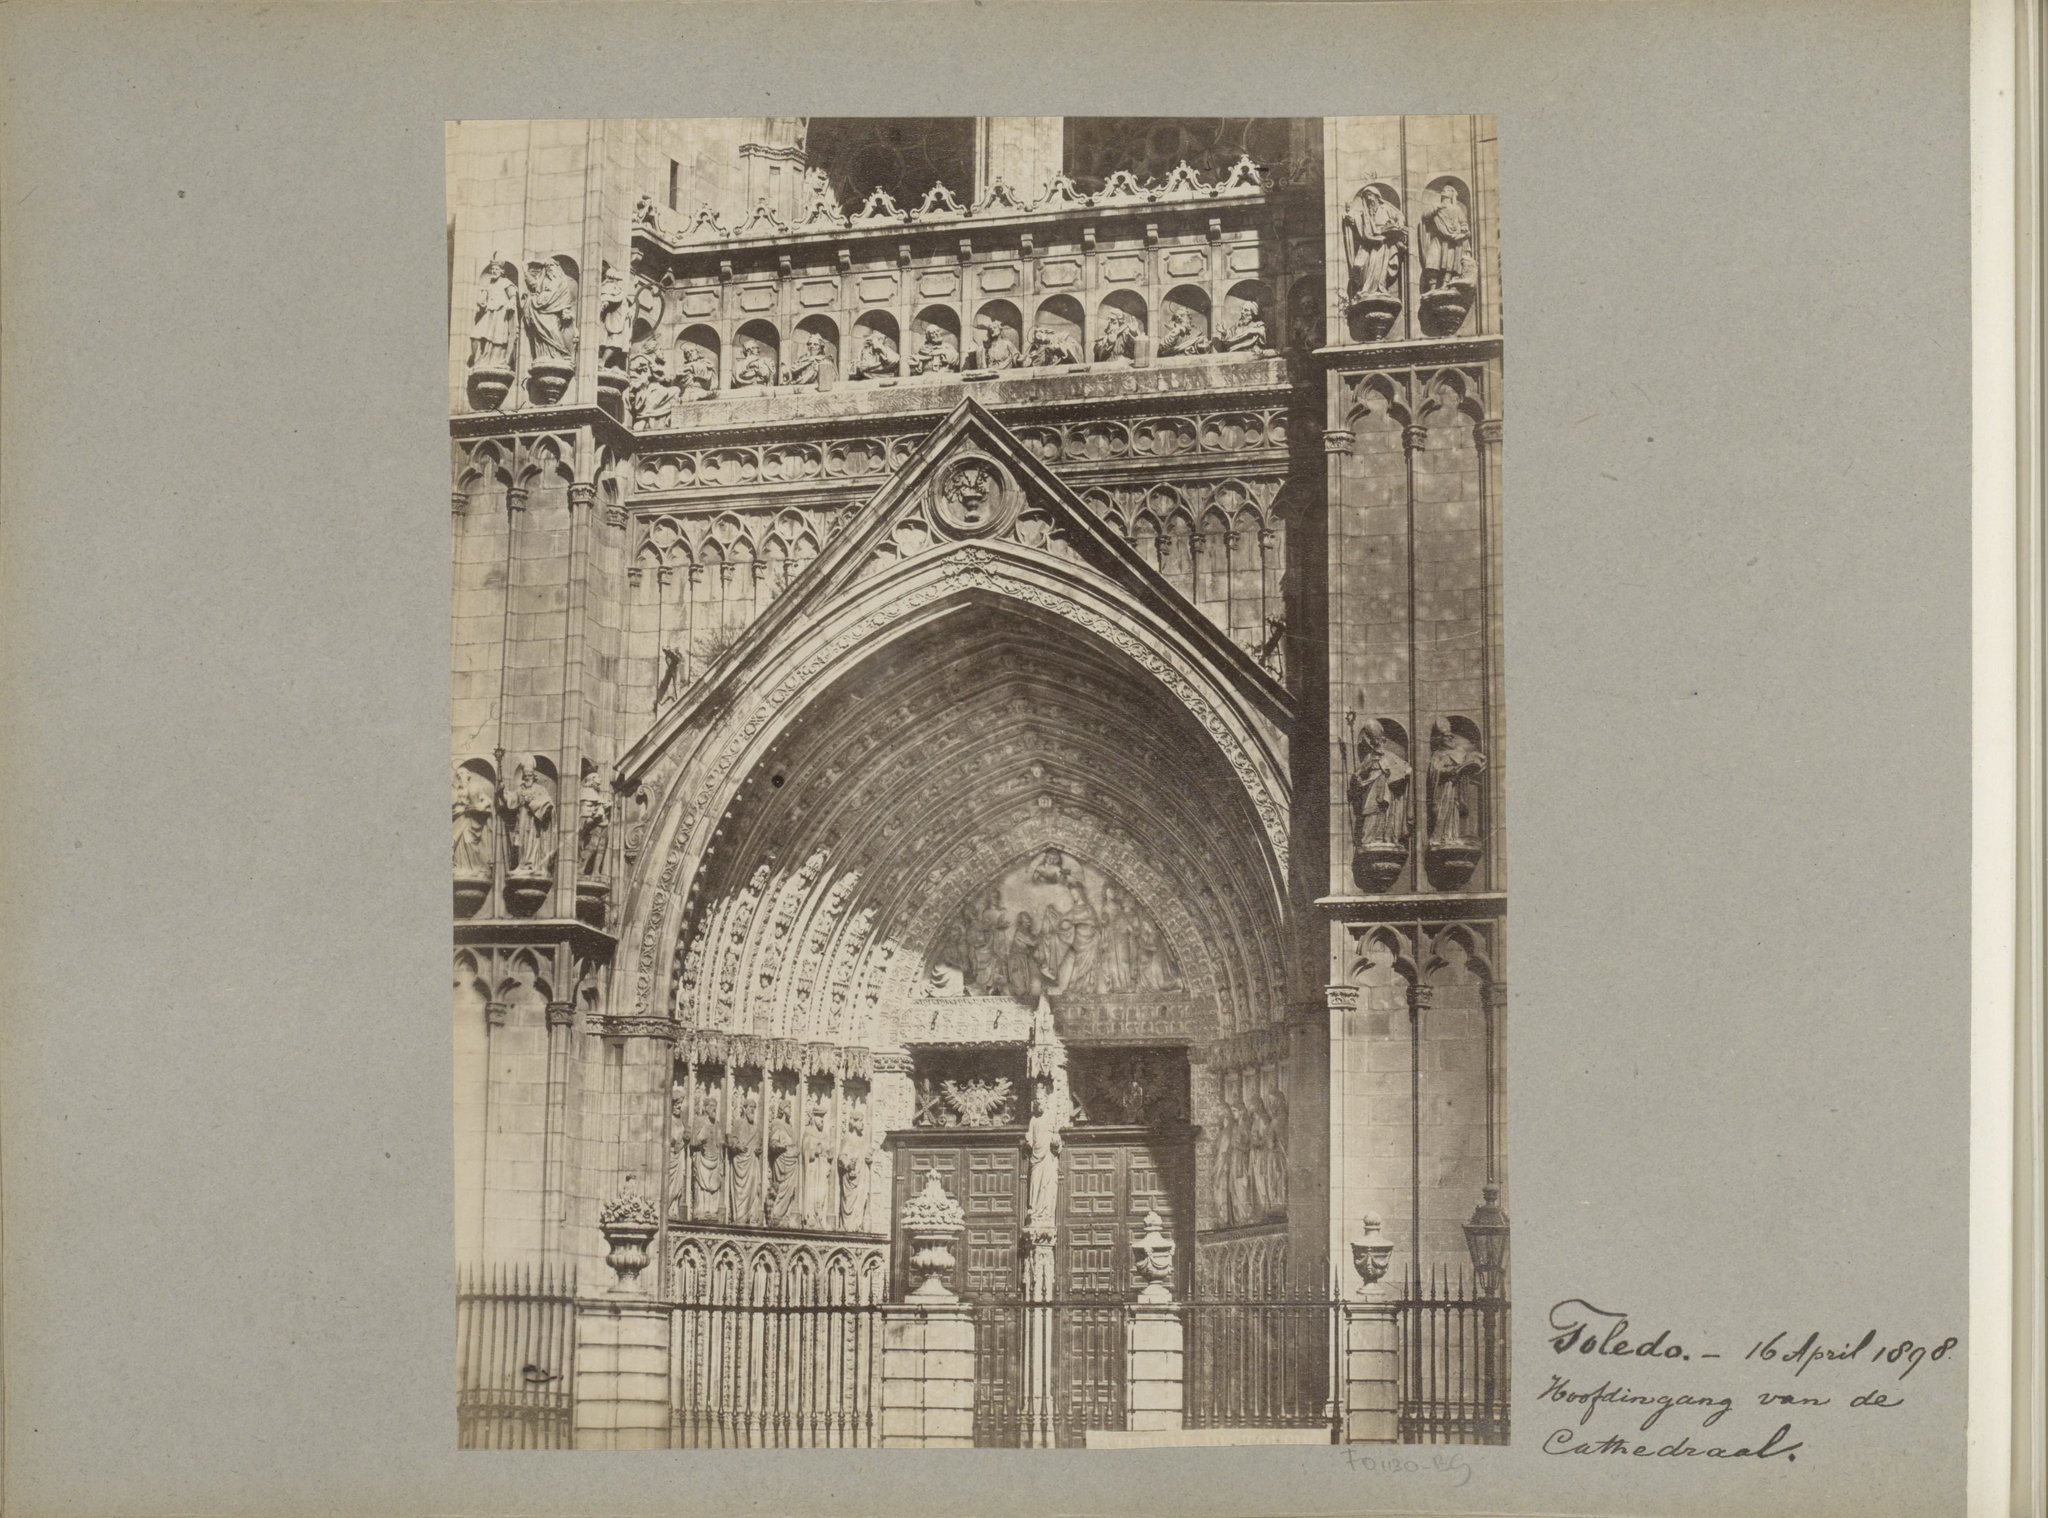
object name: album leaf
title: Hoofdportaal van de kathedraal van Toledo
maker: Anonymous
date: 1880-1898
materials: paper, photographic support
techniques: albumen print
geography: toledo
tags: parts of church exterior and annexes: portal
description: Onderdeel van Reisalbum met foto's van bezienswaardigheden in Frankrijk, Spanje, Italië, Duitsland, Zwitserland en Oostenrijk.